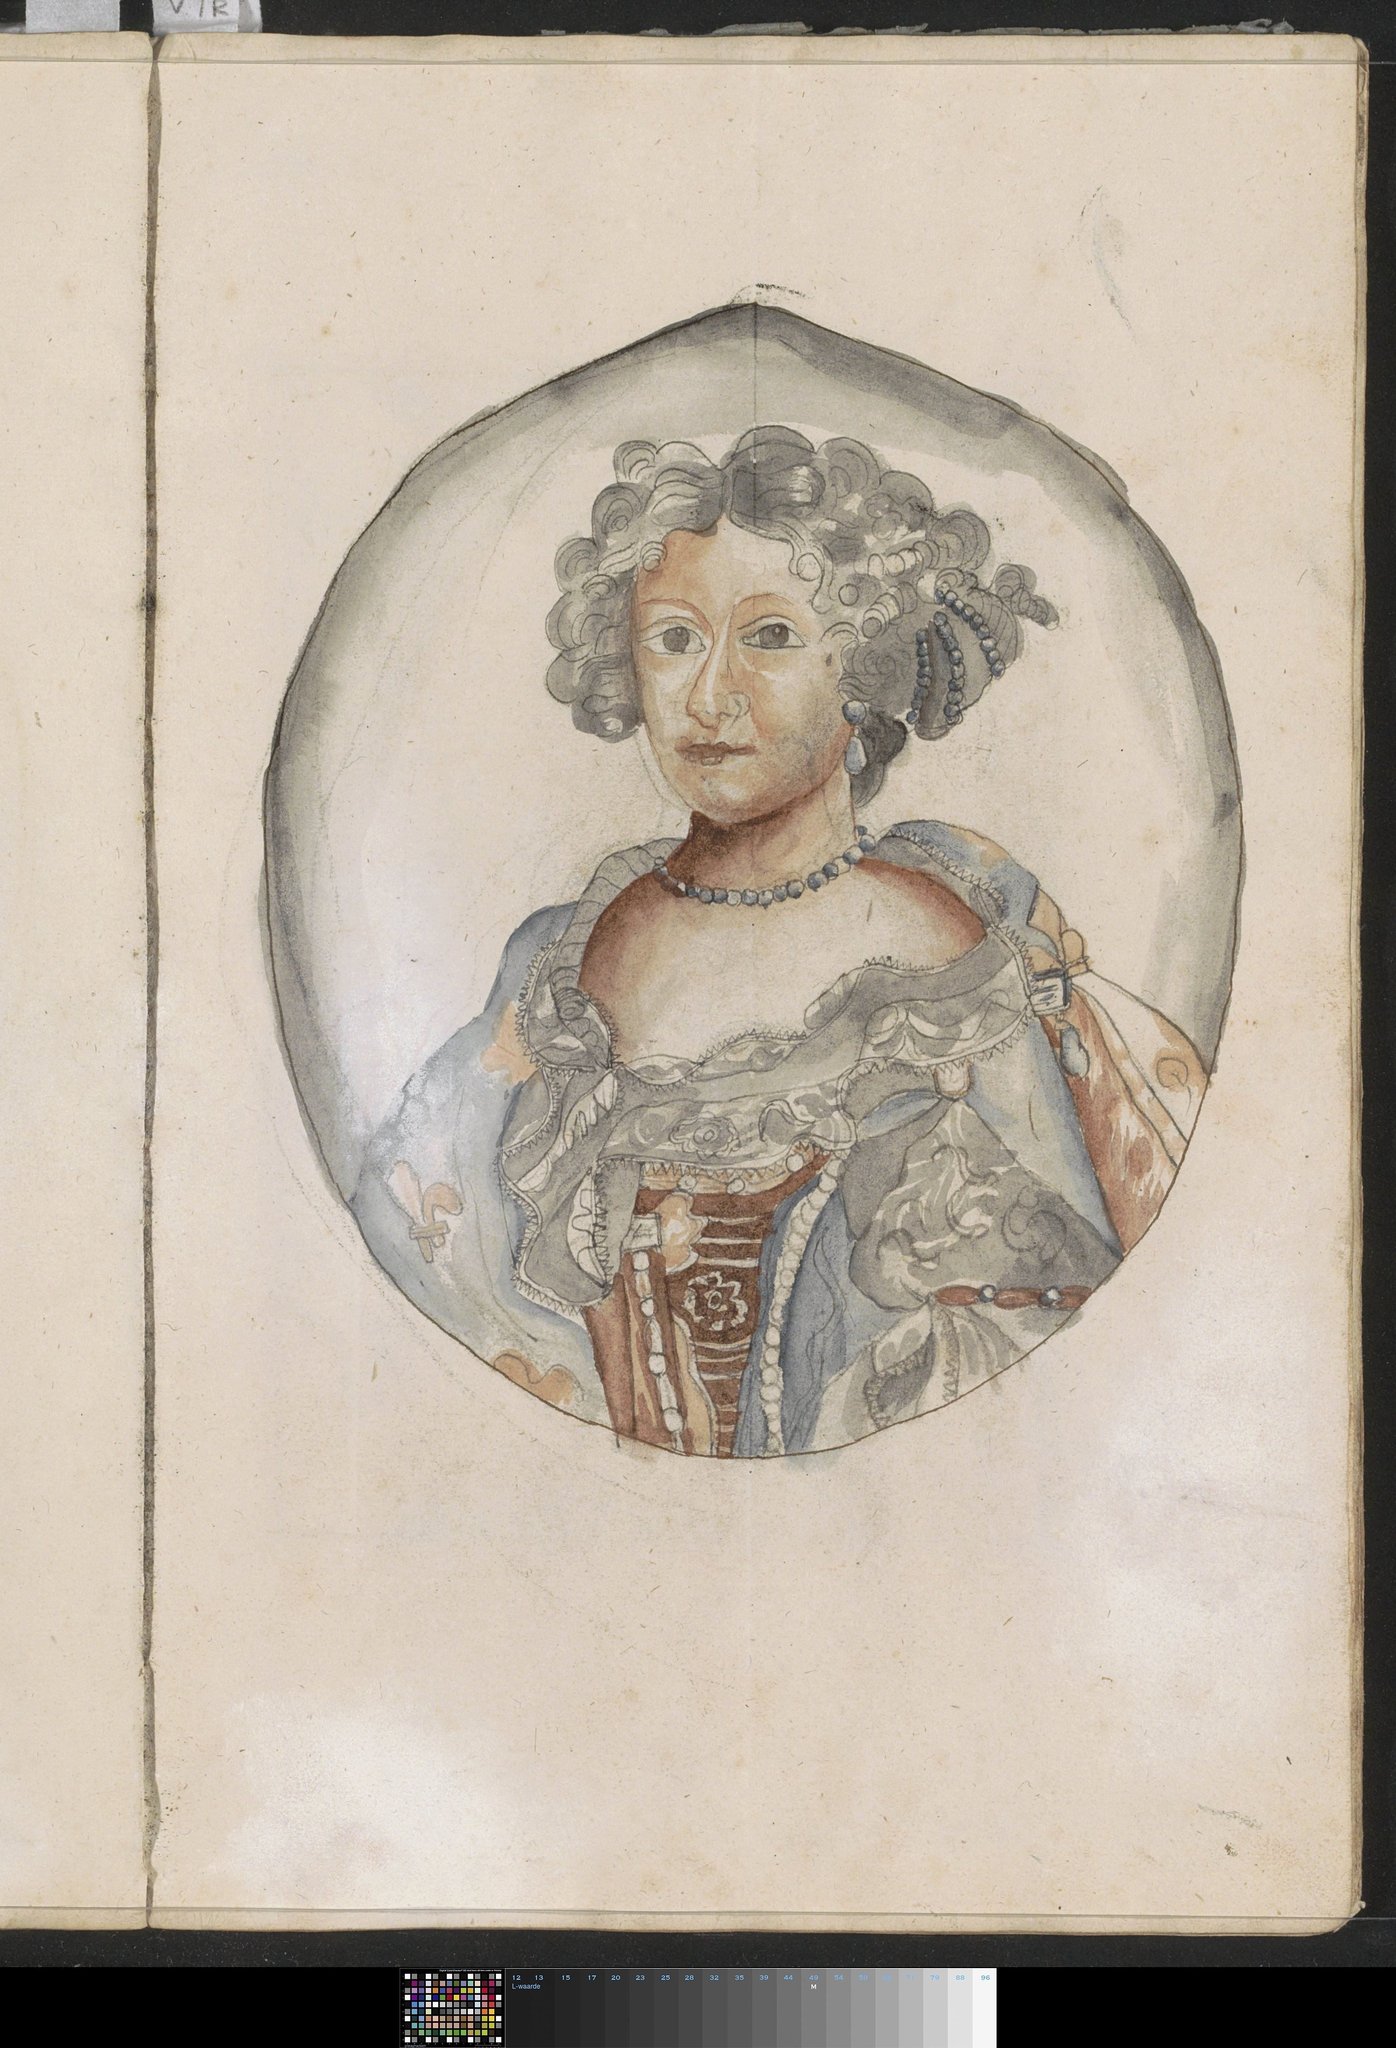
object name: sketchbook leaf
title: Portret van een vrouw met parels in het haar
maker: hendrick van beaumont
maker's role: draughtsman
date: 1696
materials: paper, pencil, watercolor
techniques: brush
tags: historical persons (portraits and scenes from the life)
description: Portret in een ovaal. Blad 78 recto uit een schetsboek met 91 bladen.